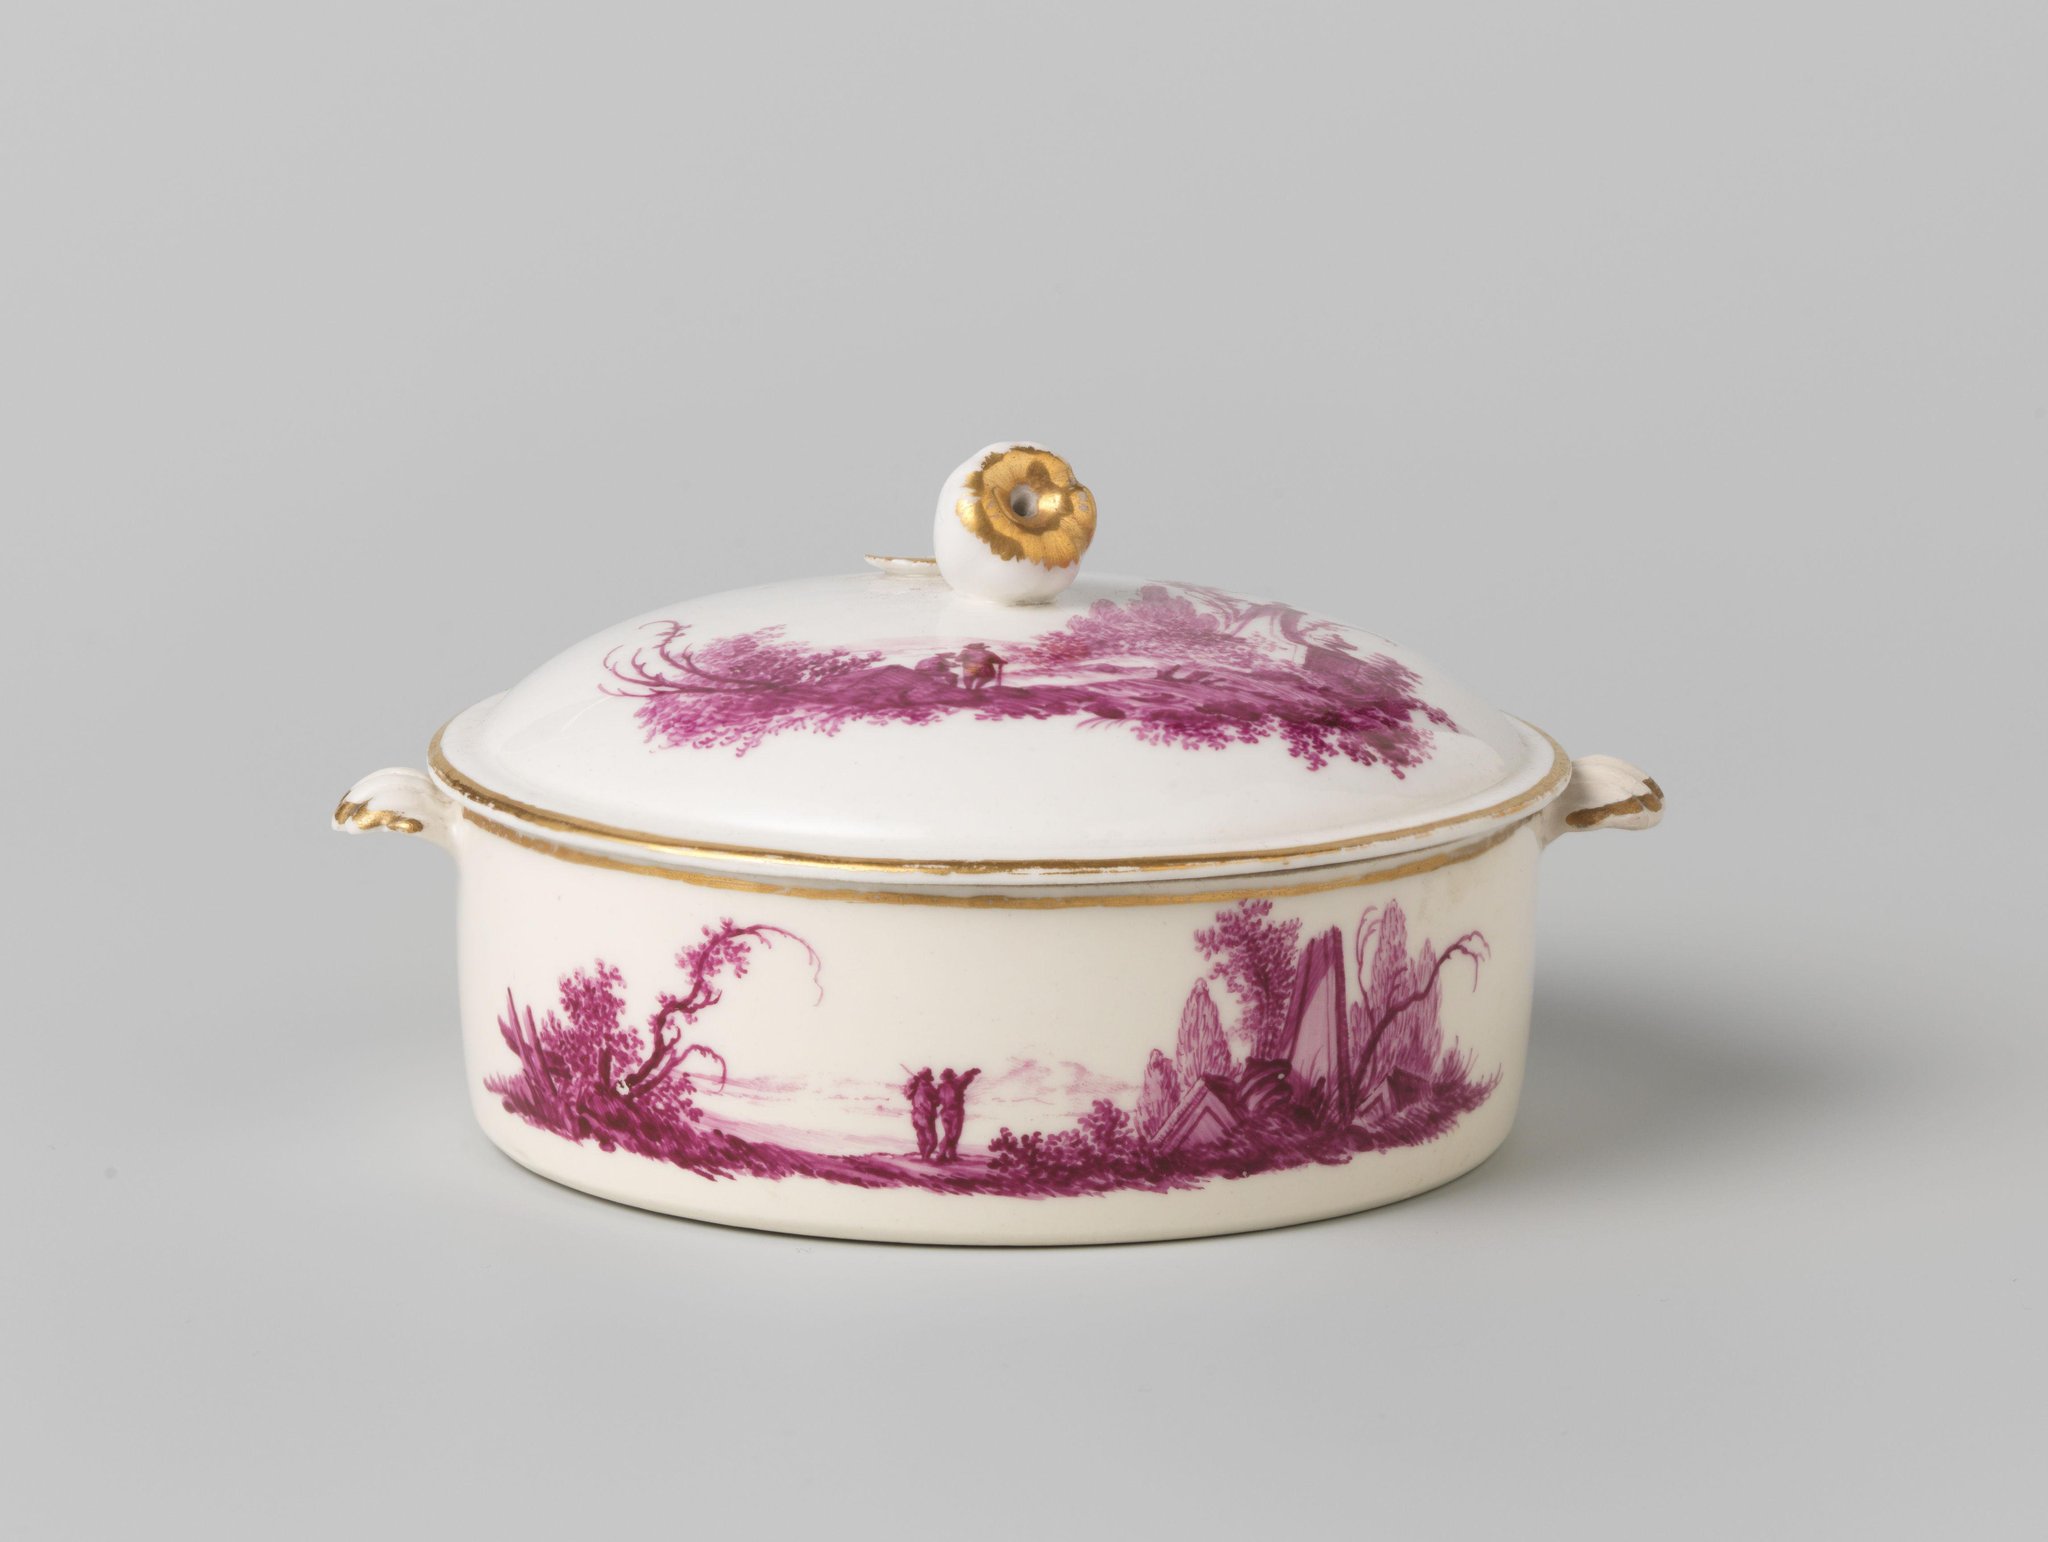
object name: butter dish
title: Deksel van botervloot, beschilderd met rivierlandschappen met figuren en monumenten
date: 1774-1778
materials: porcelain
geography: loosdrecht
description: Botervloot van porselein. Schelpvormige oren, vrucht met blaadje op het deksel als knop. Aan beide zijden en op het deksel beschilderd met rivierlandschappen met figuren en monumenten in bietenrood. Ornament in goud op de oren en dekselknop. Gouden bies langs mond- en dekselrand.